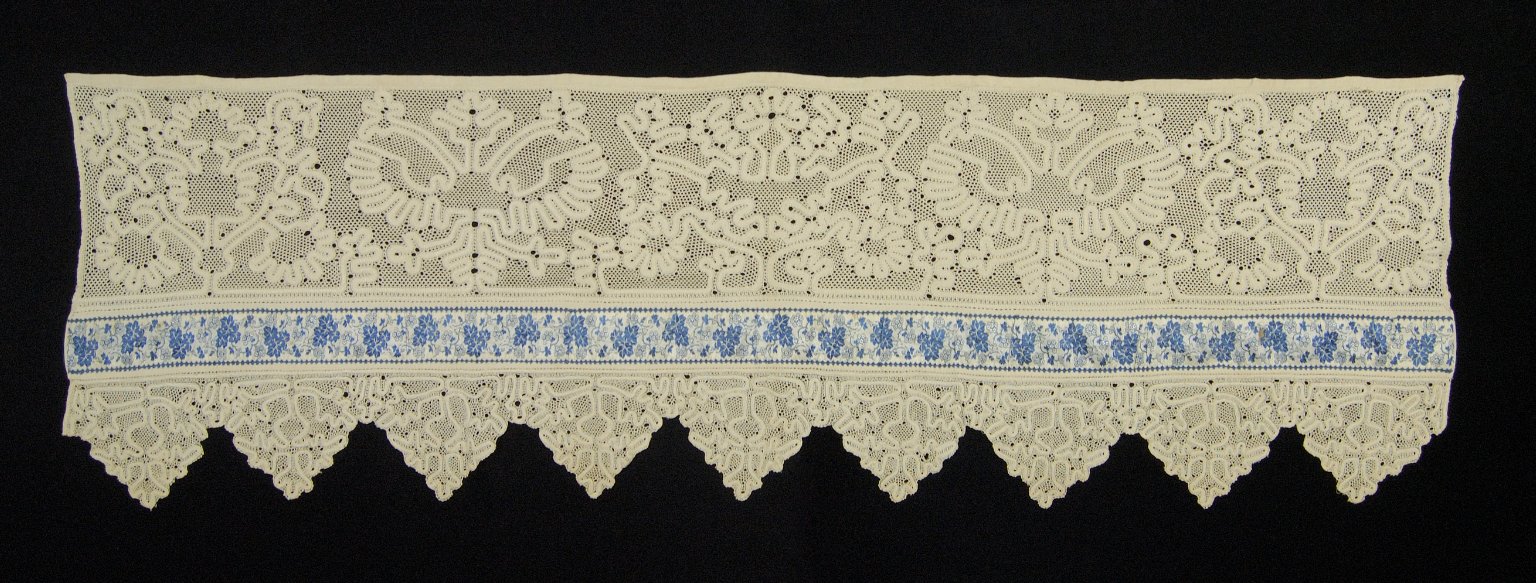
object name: border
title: Bed curtain border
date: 1826-1850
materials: linen, silk